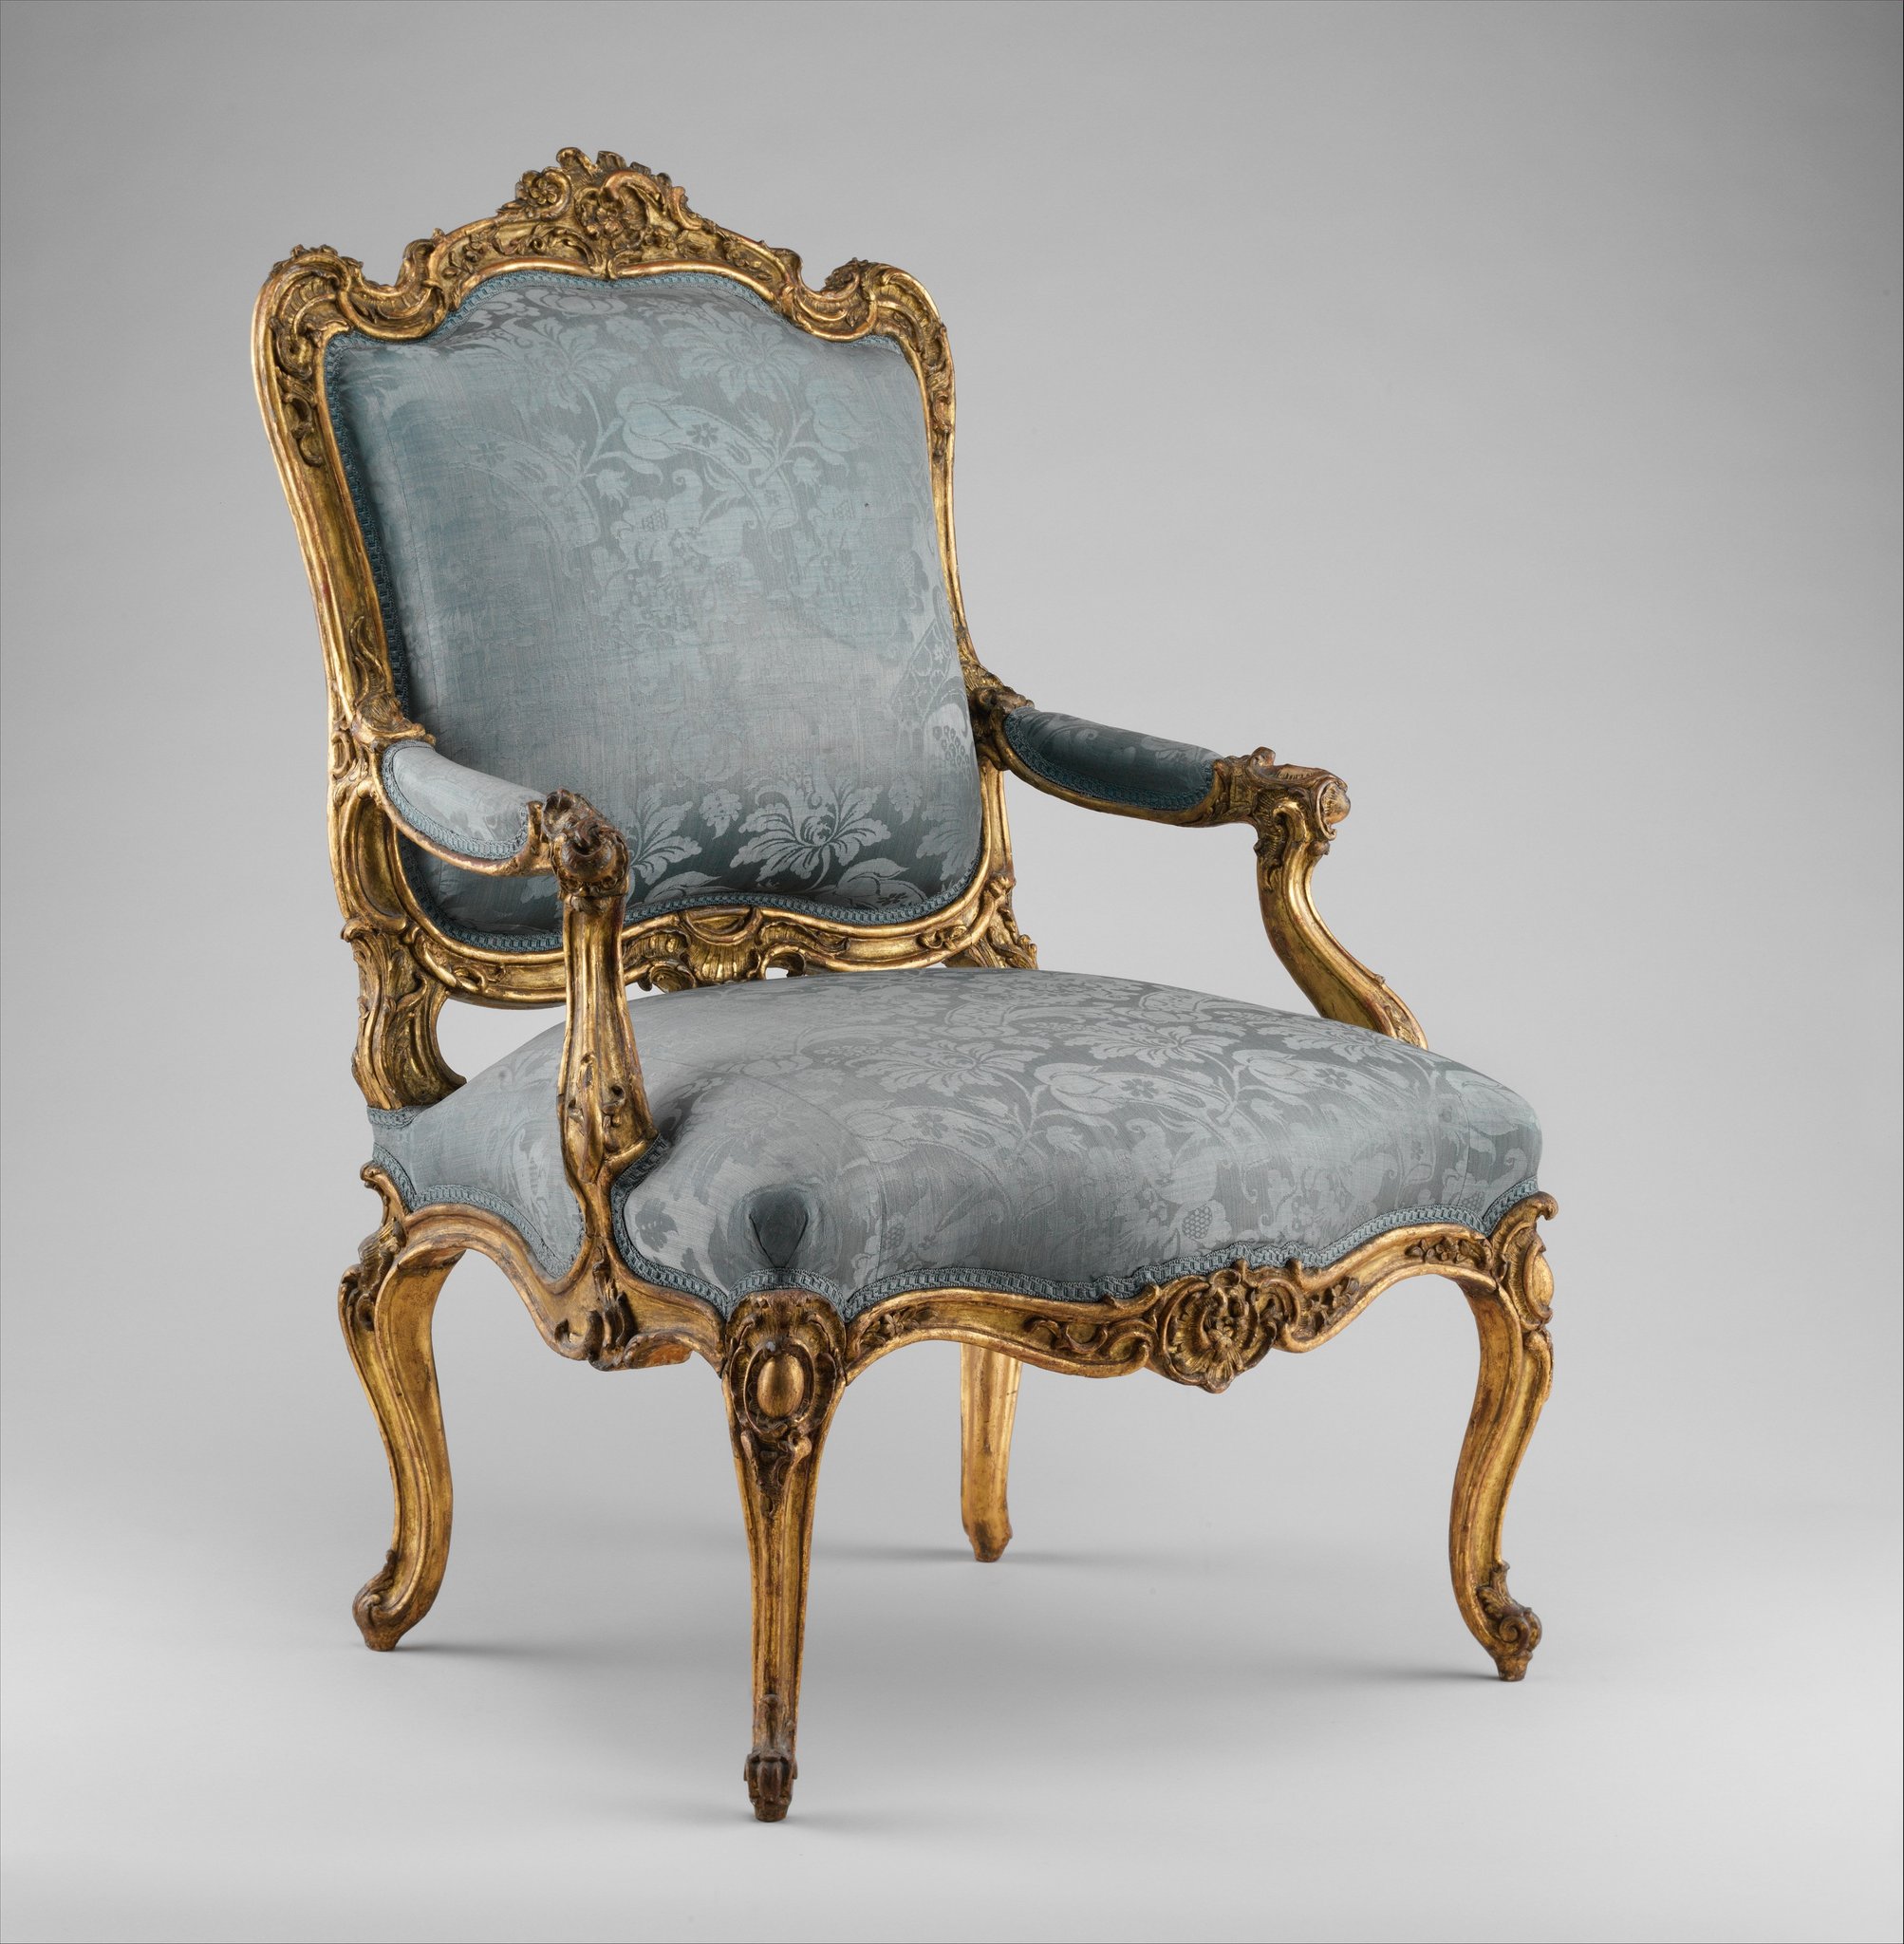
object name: armchair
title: Armchair (fauteuil à la reine)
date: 1750-1760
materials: wood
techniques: carving, damask, gilding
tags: flowers